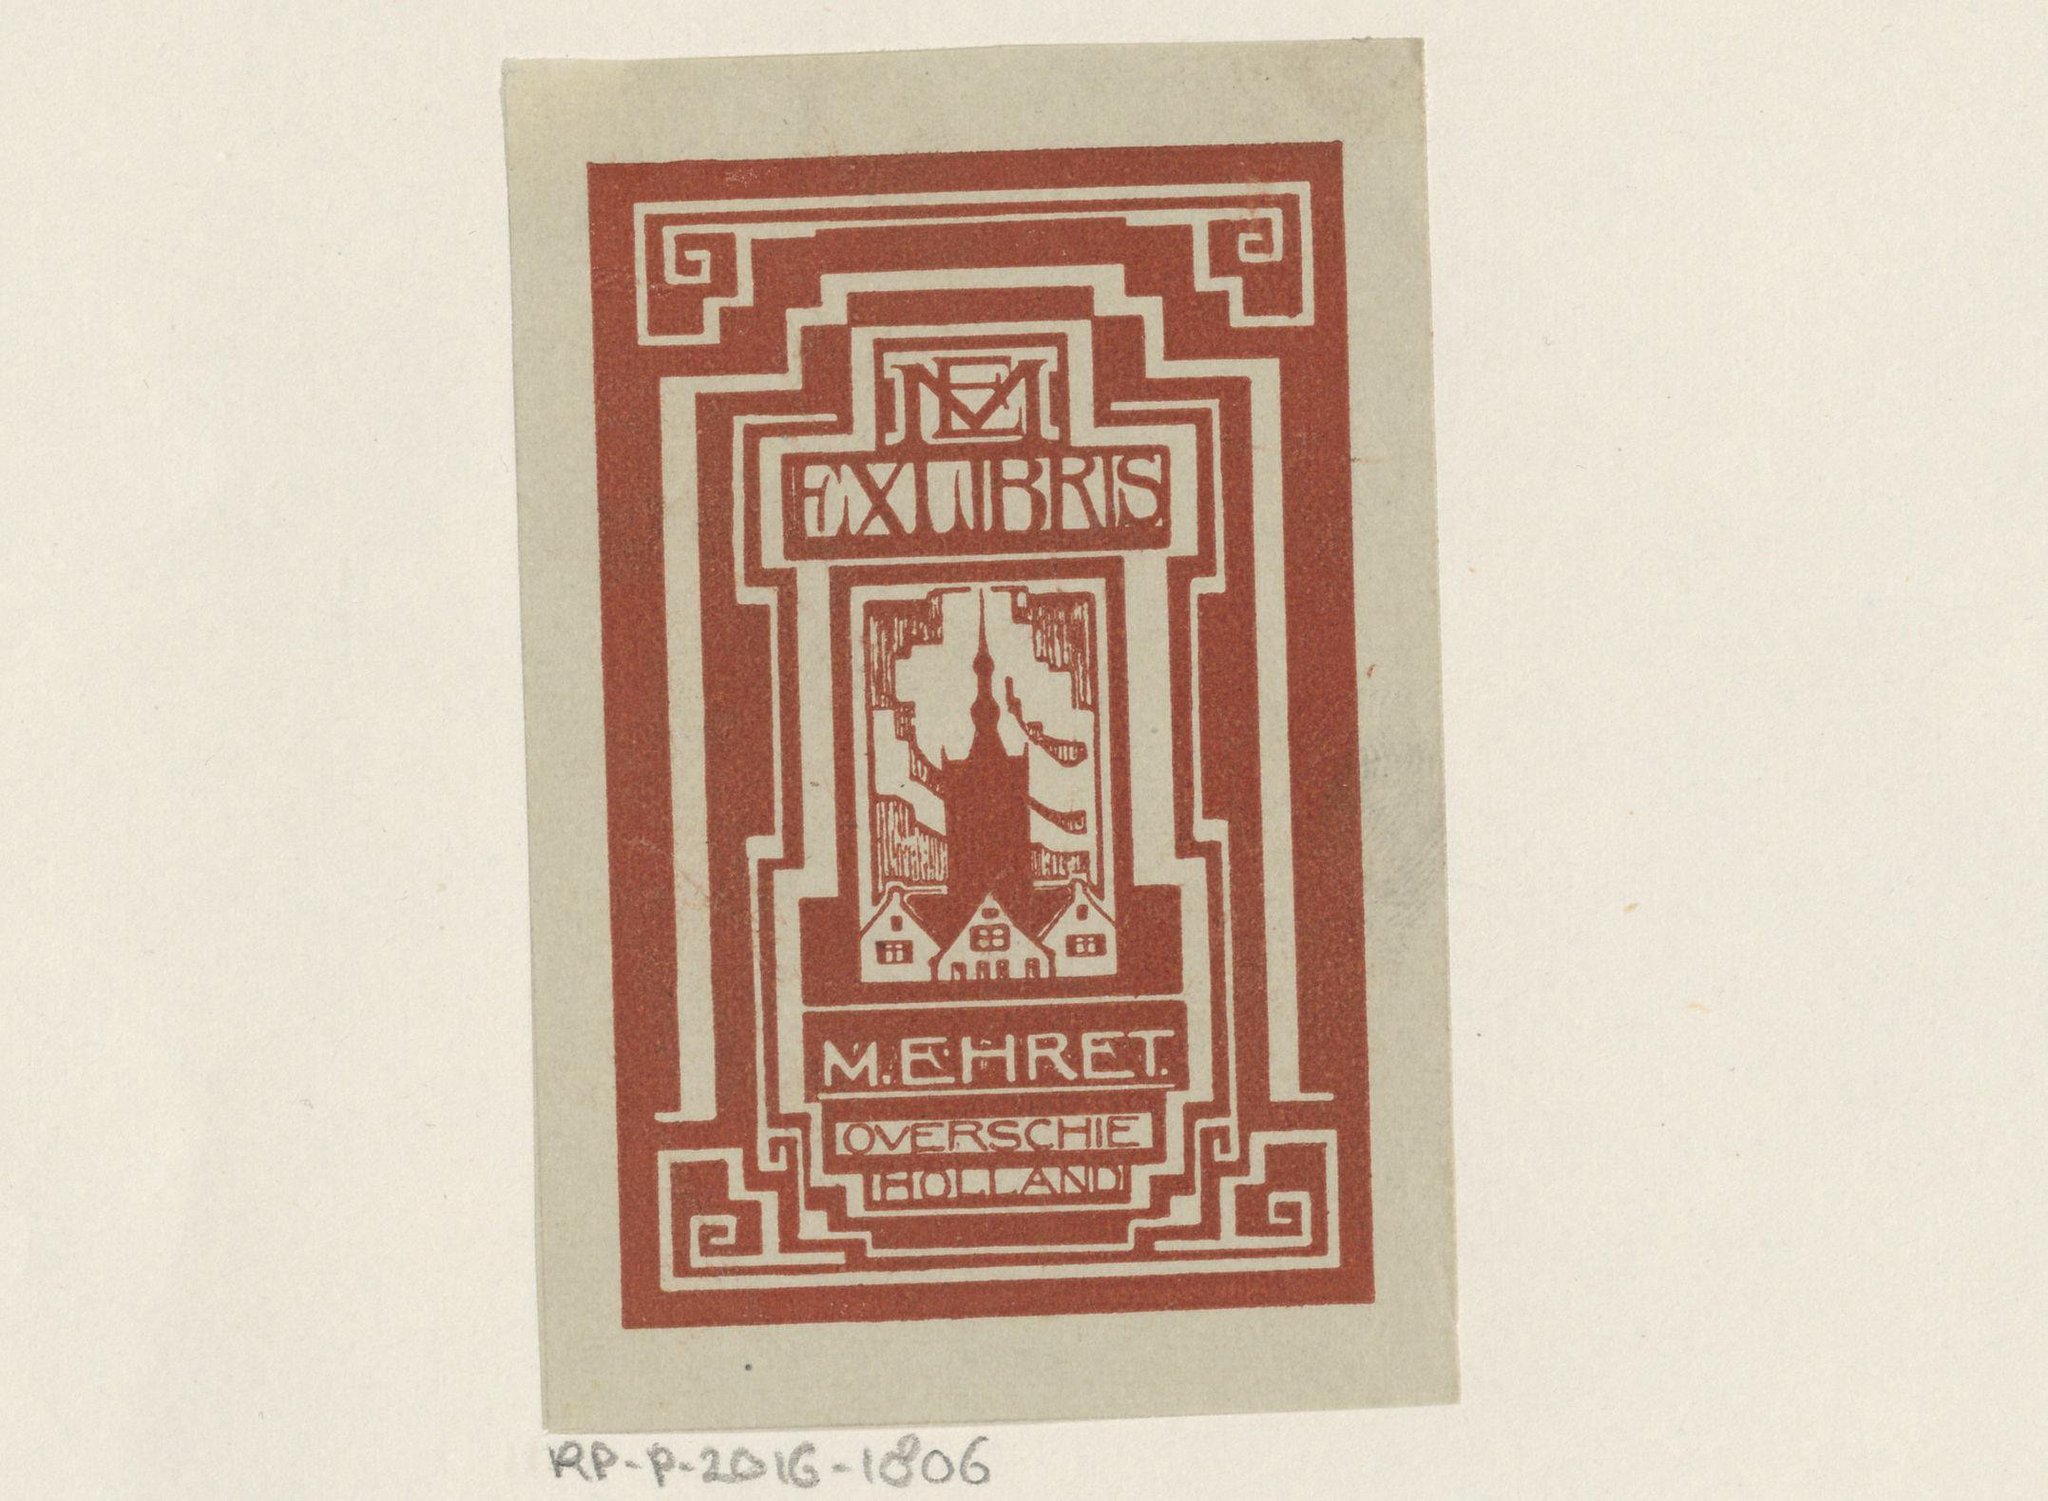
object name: bookplate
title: Ex libris van M. Ehret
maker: Anonymous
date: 1900-1999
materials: paper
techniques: printing block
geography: netherlands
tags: parts of church exterior and annexes: tower, overschie